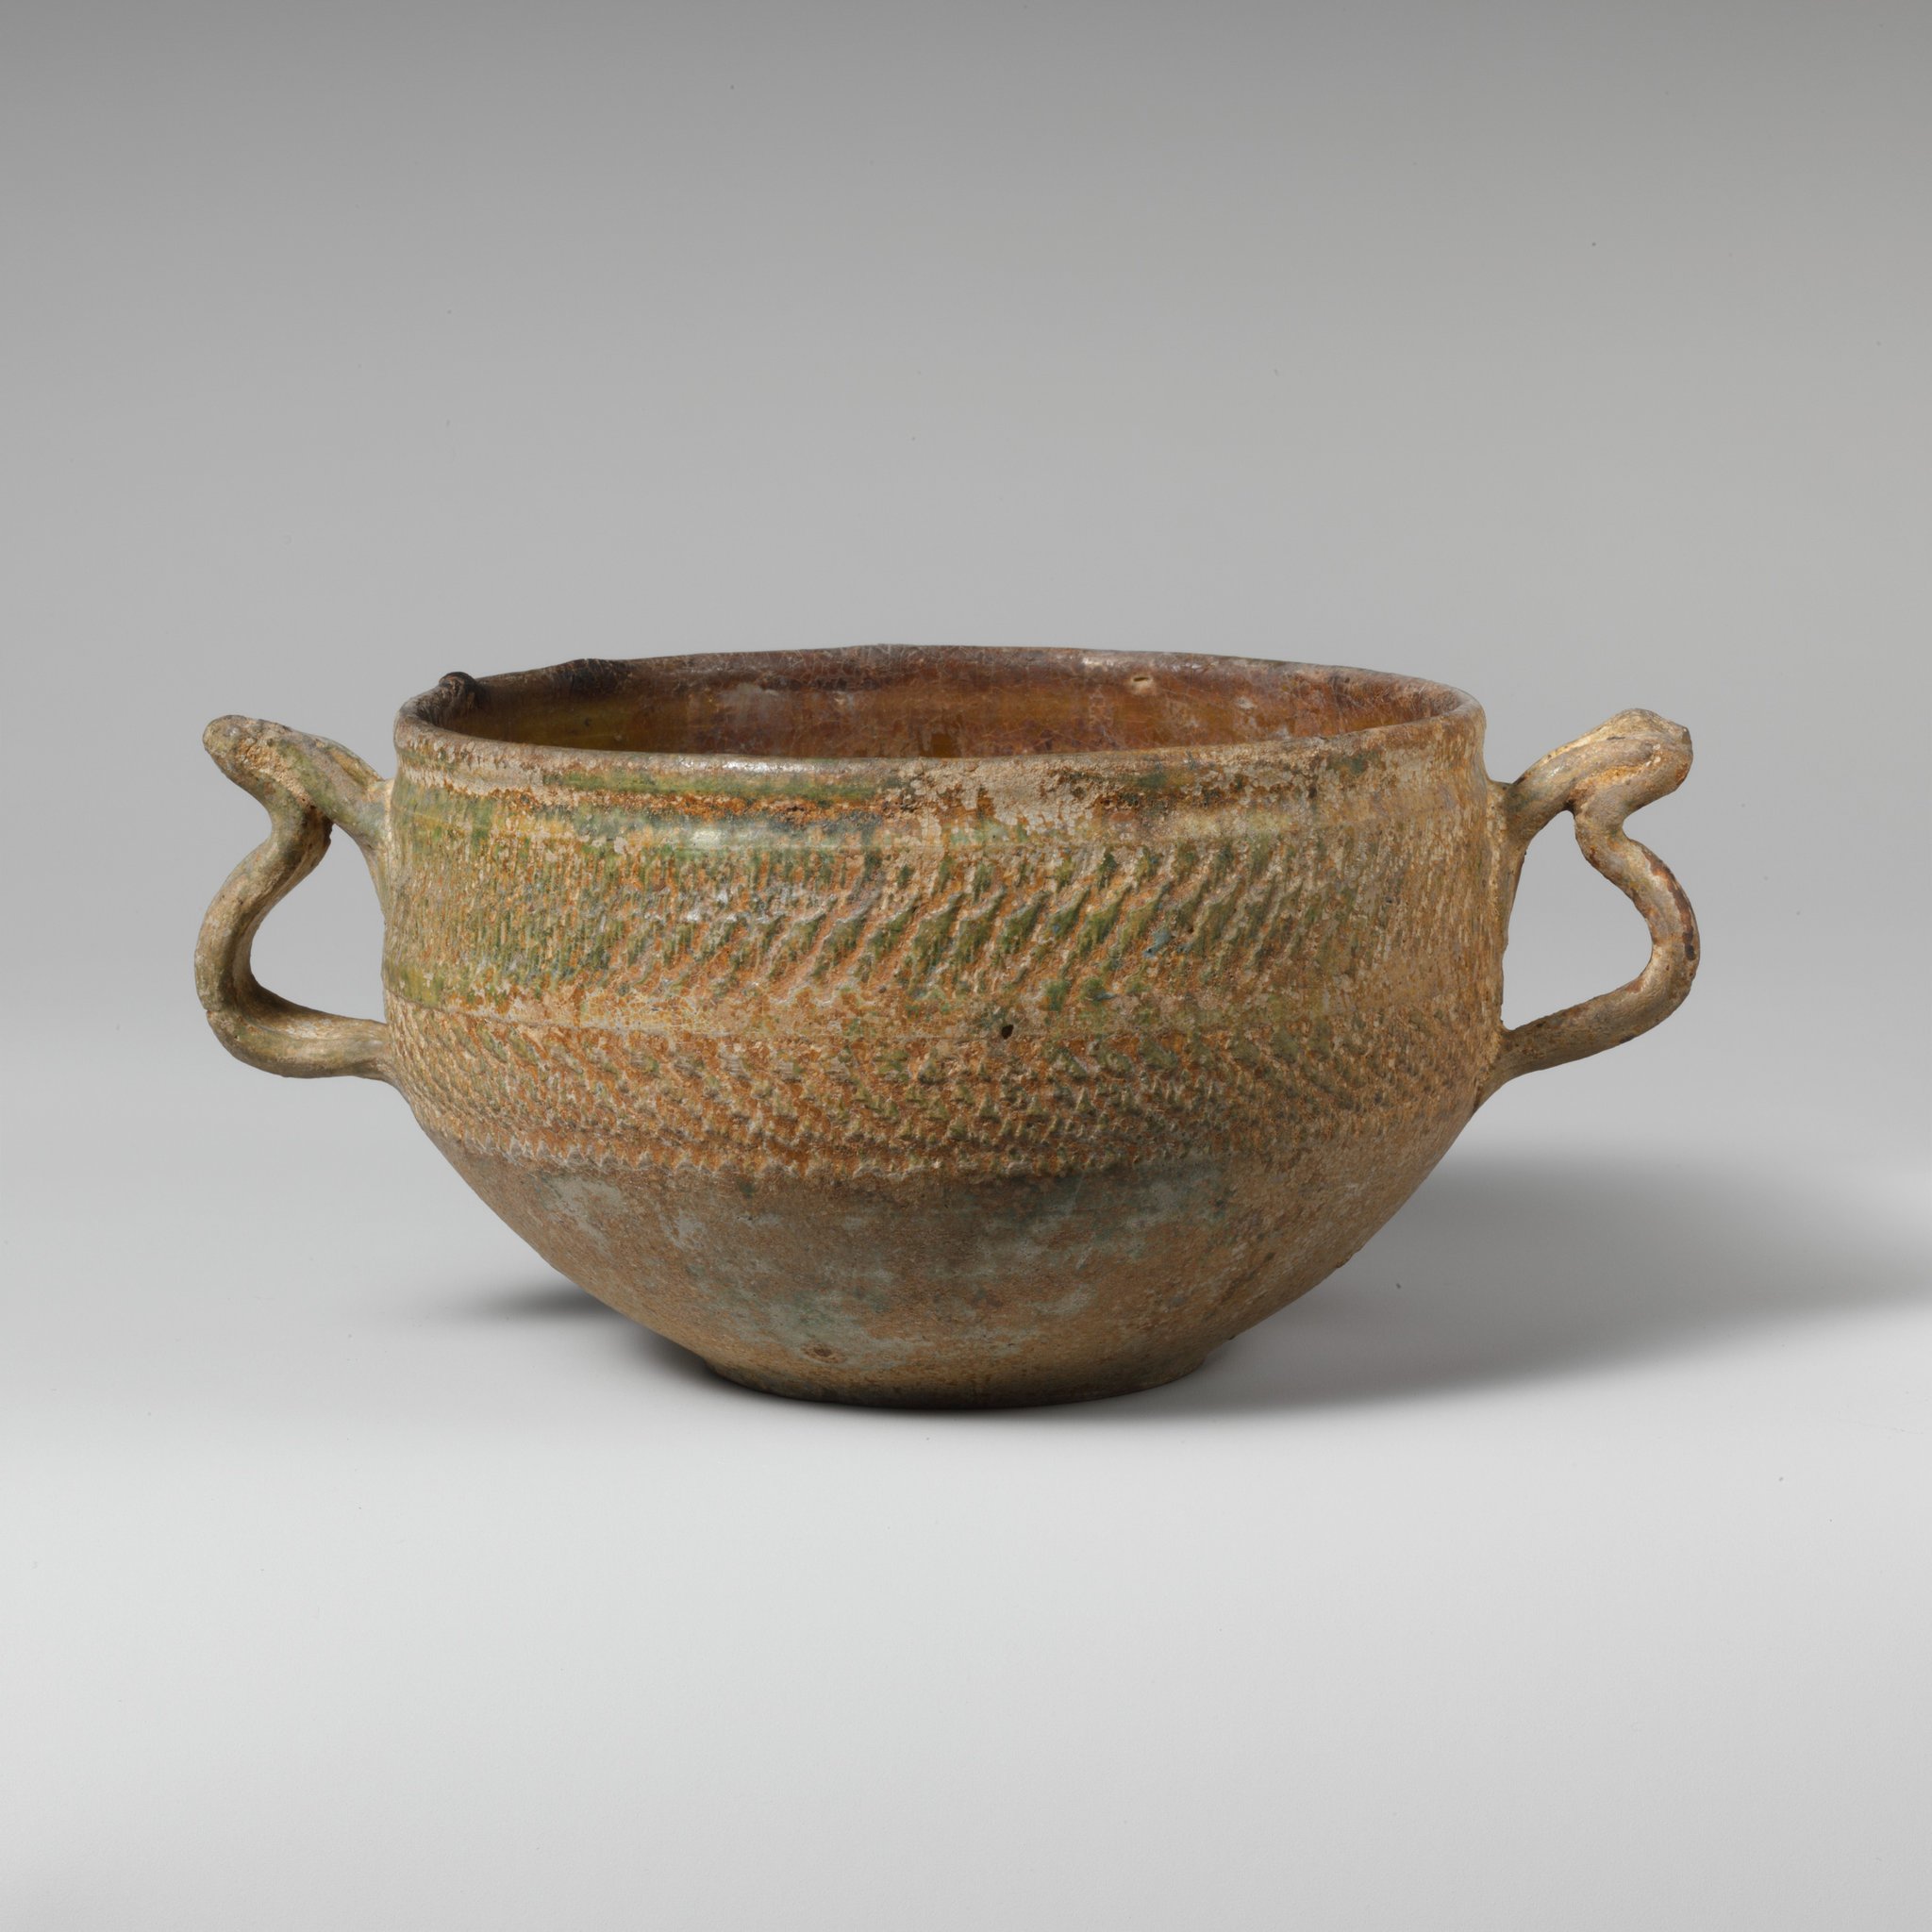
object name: skyphos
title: Terracotta scyphus (drinking cup)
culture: roman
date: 101-200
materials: terracotta